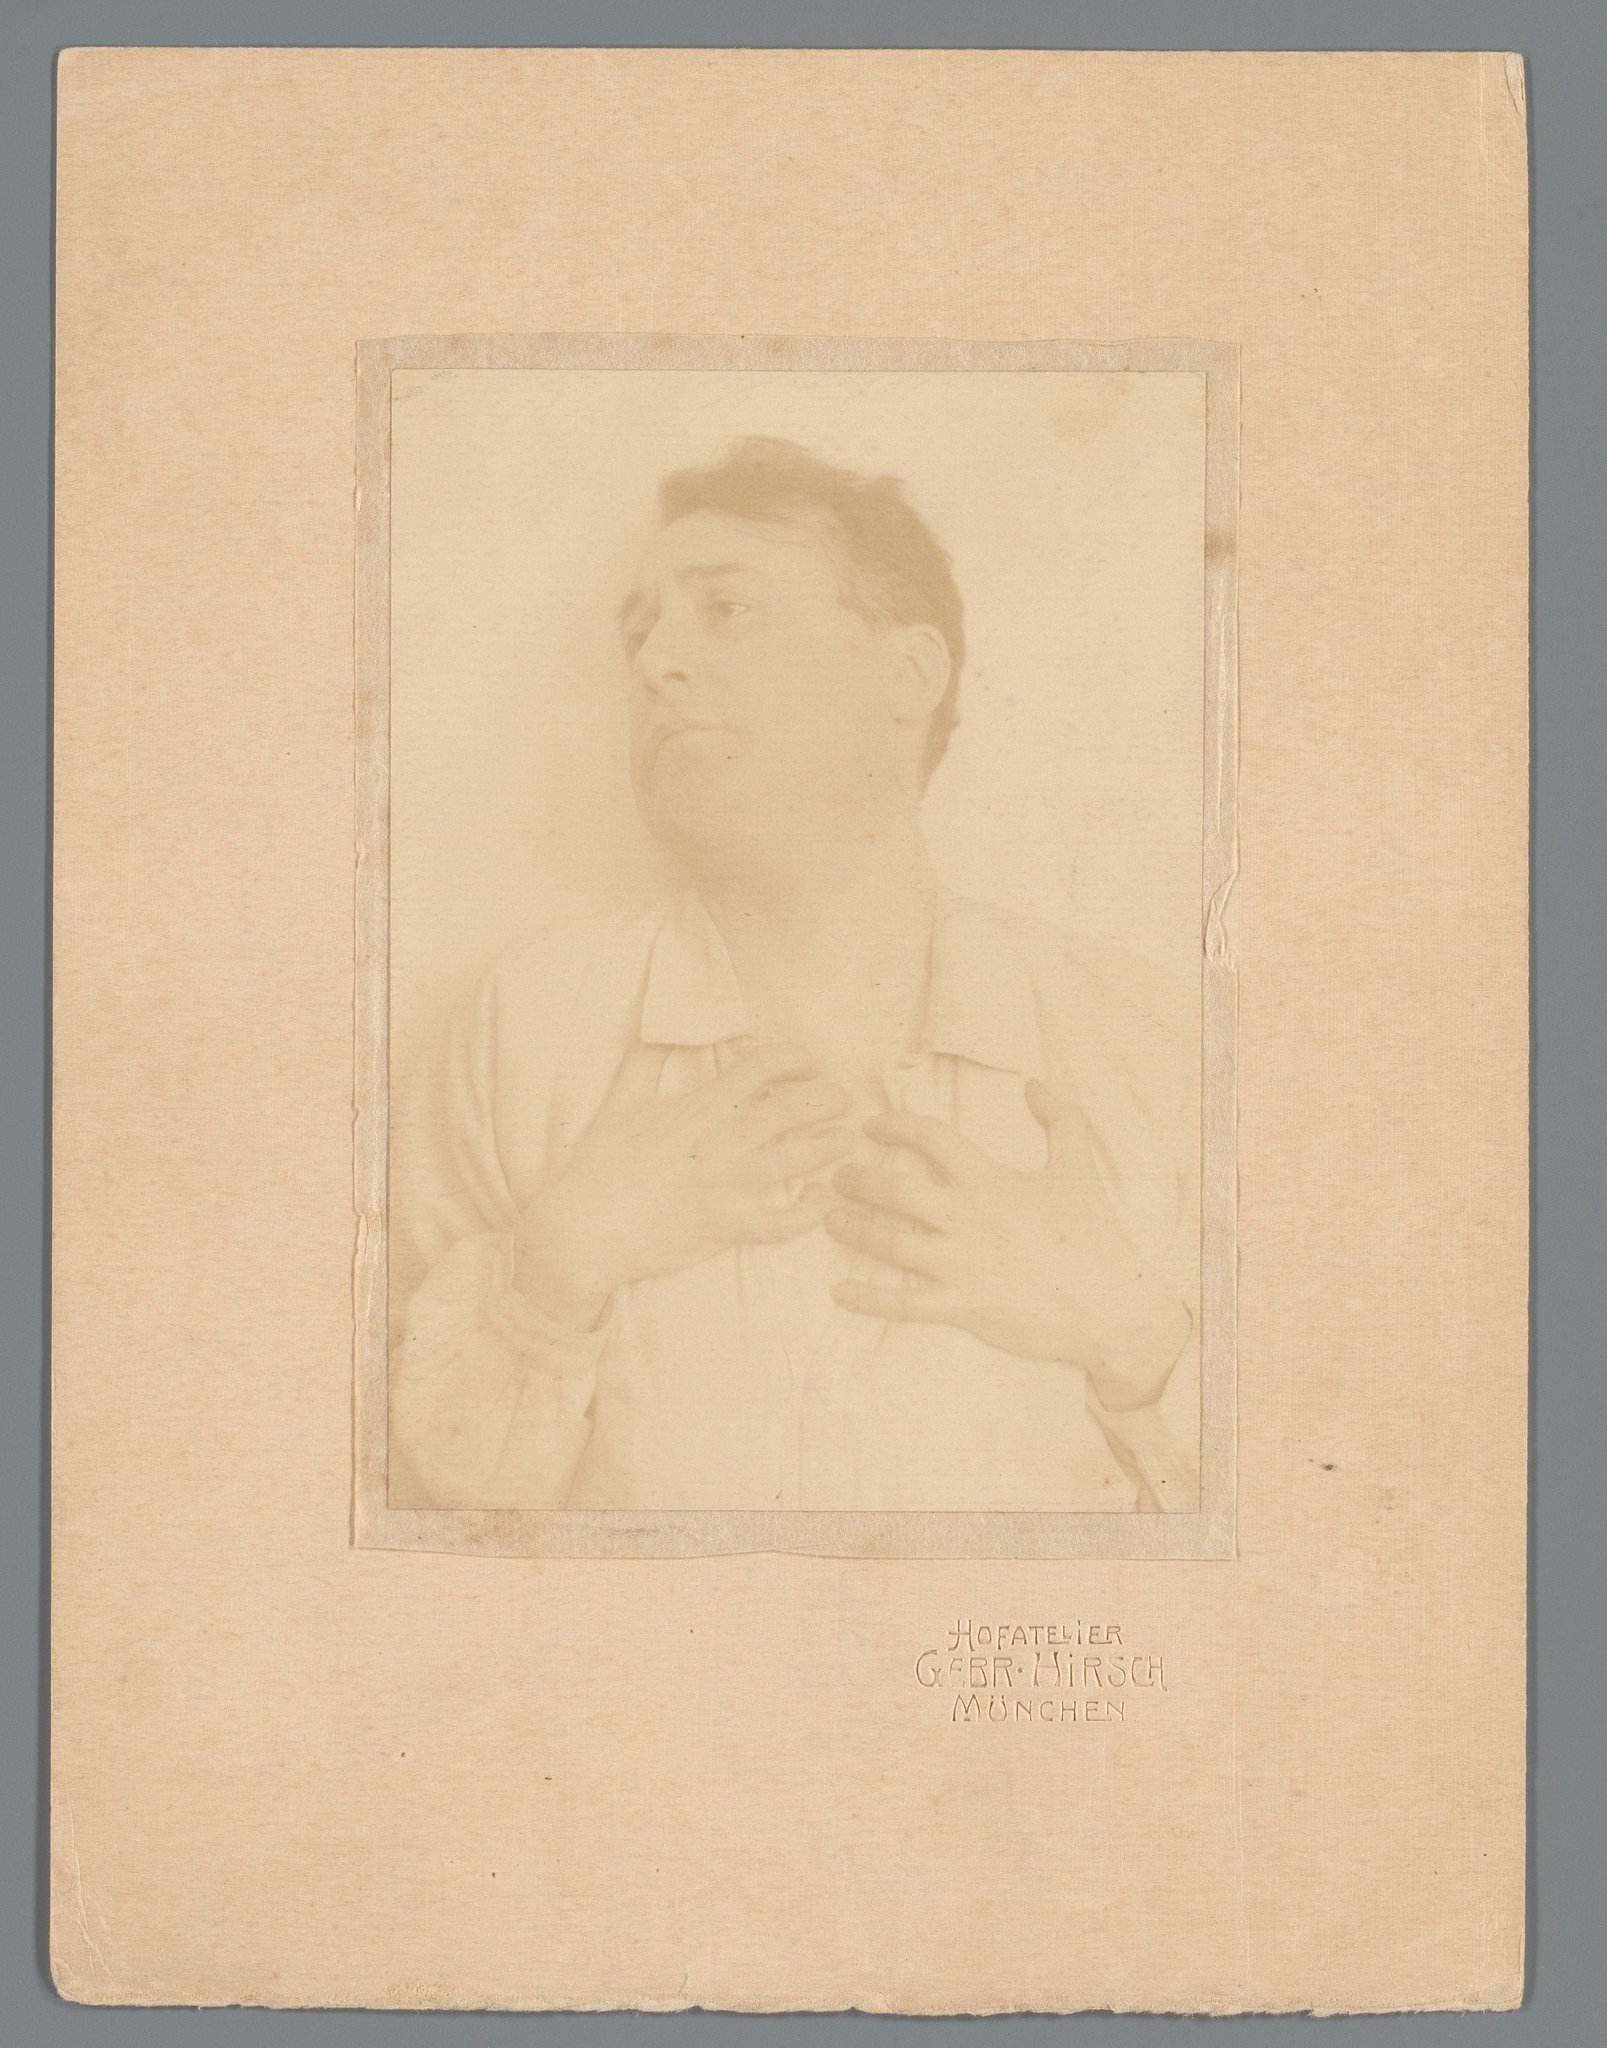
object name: photograph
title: Gioielli della Madonna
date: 1906-1914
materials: cardboard, paper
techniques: albumen print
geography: munich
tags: amsterdam, paris, historical persons (portraits and scenes from the life)